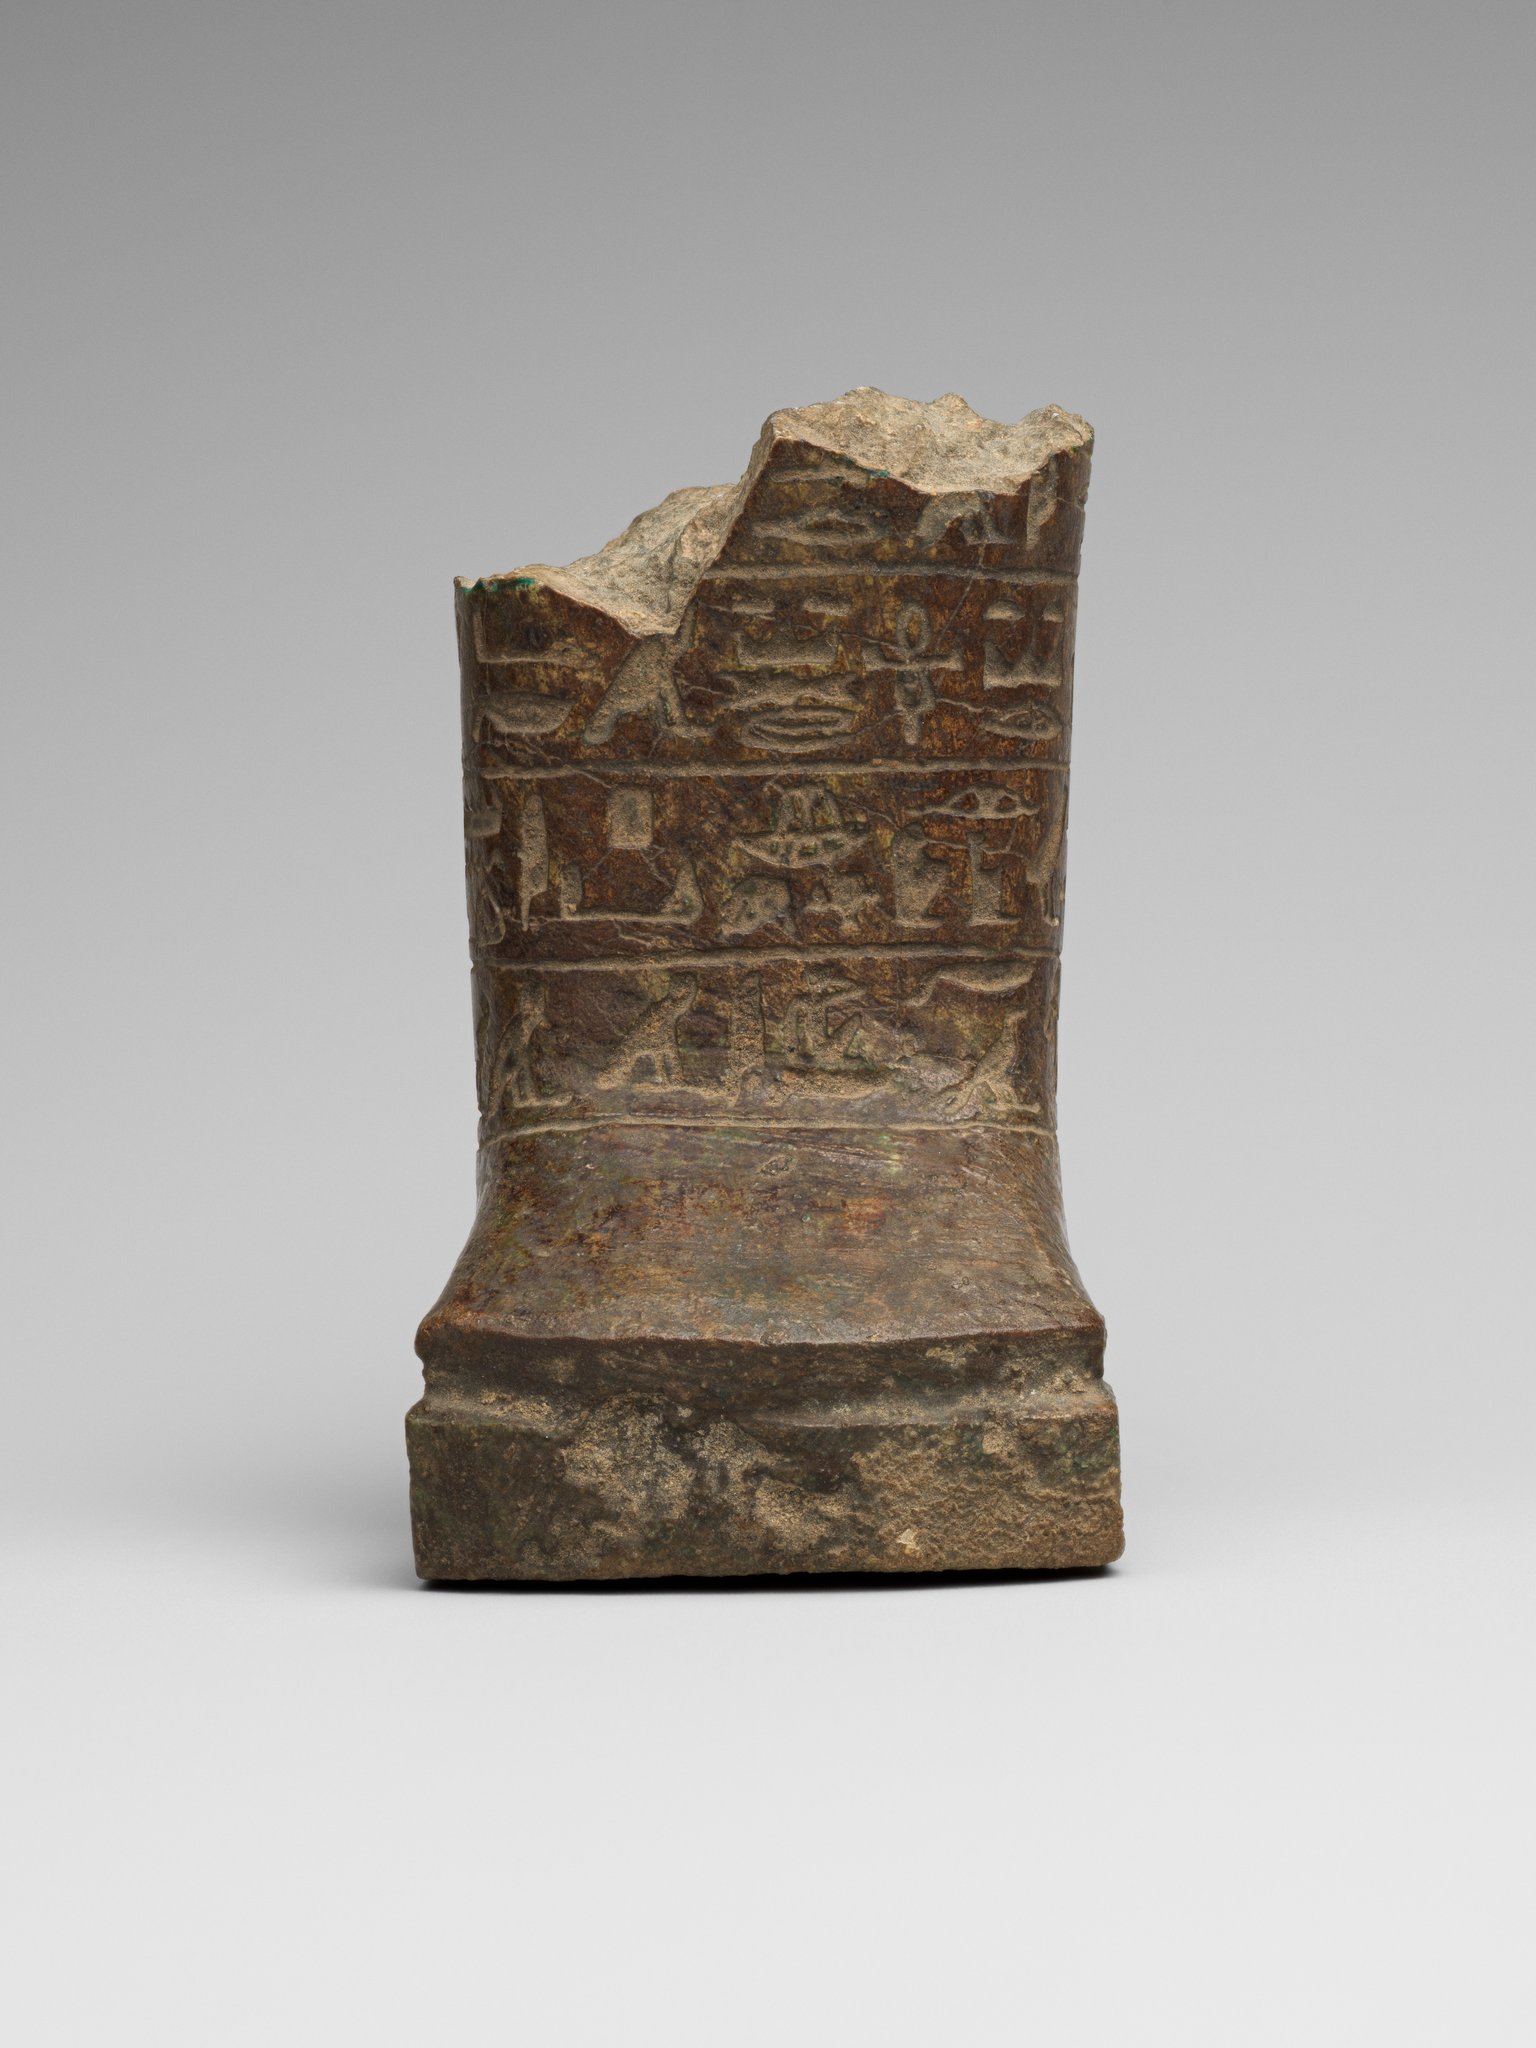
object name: shabti fragment, petamenophis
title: Shabti fragment of Petamenophis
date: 710-640 BCE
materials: stone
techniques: glazing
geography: egypt